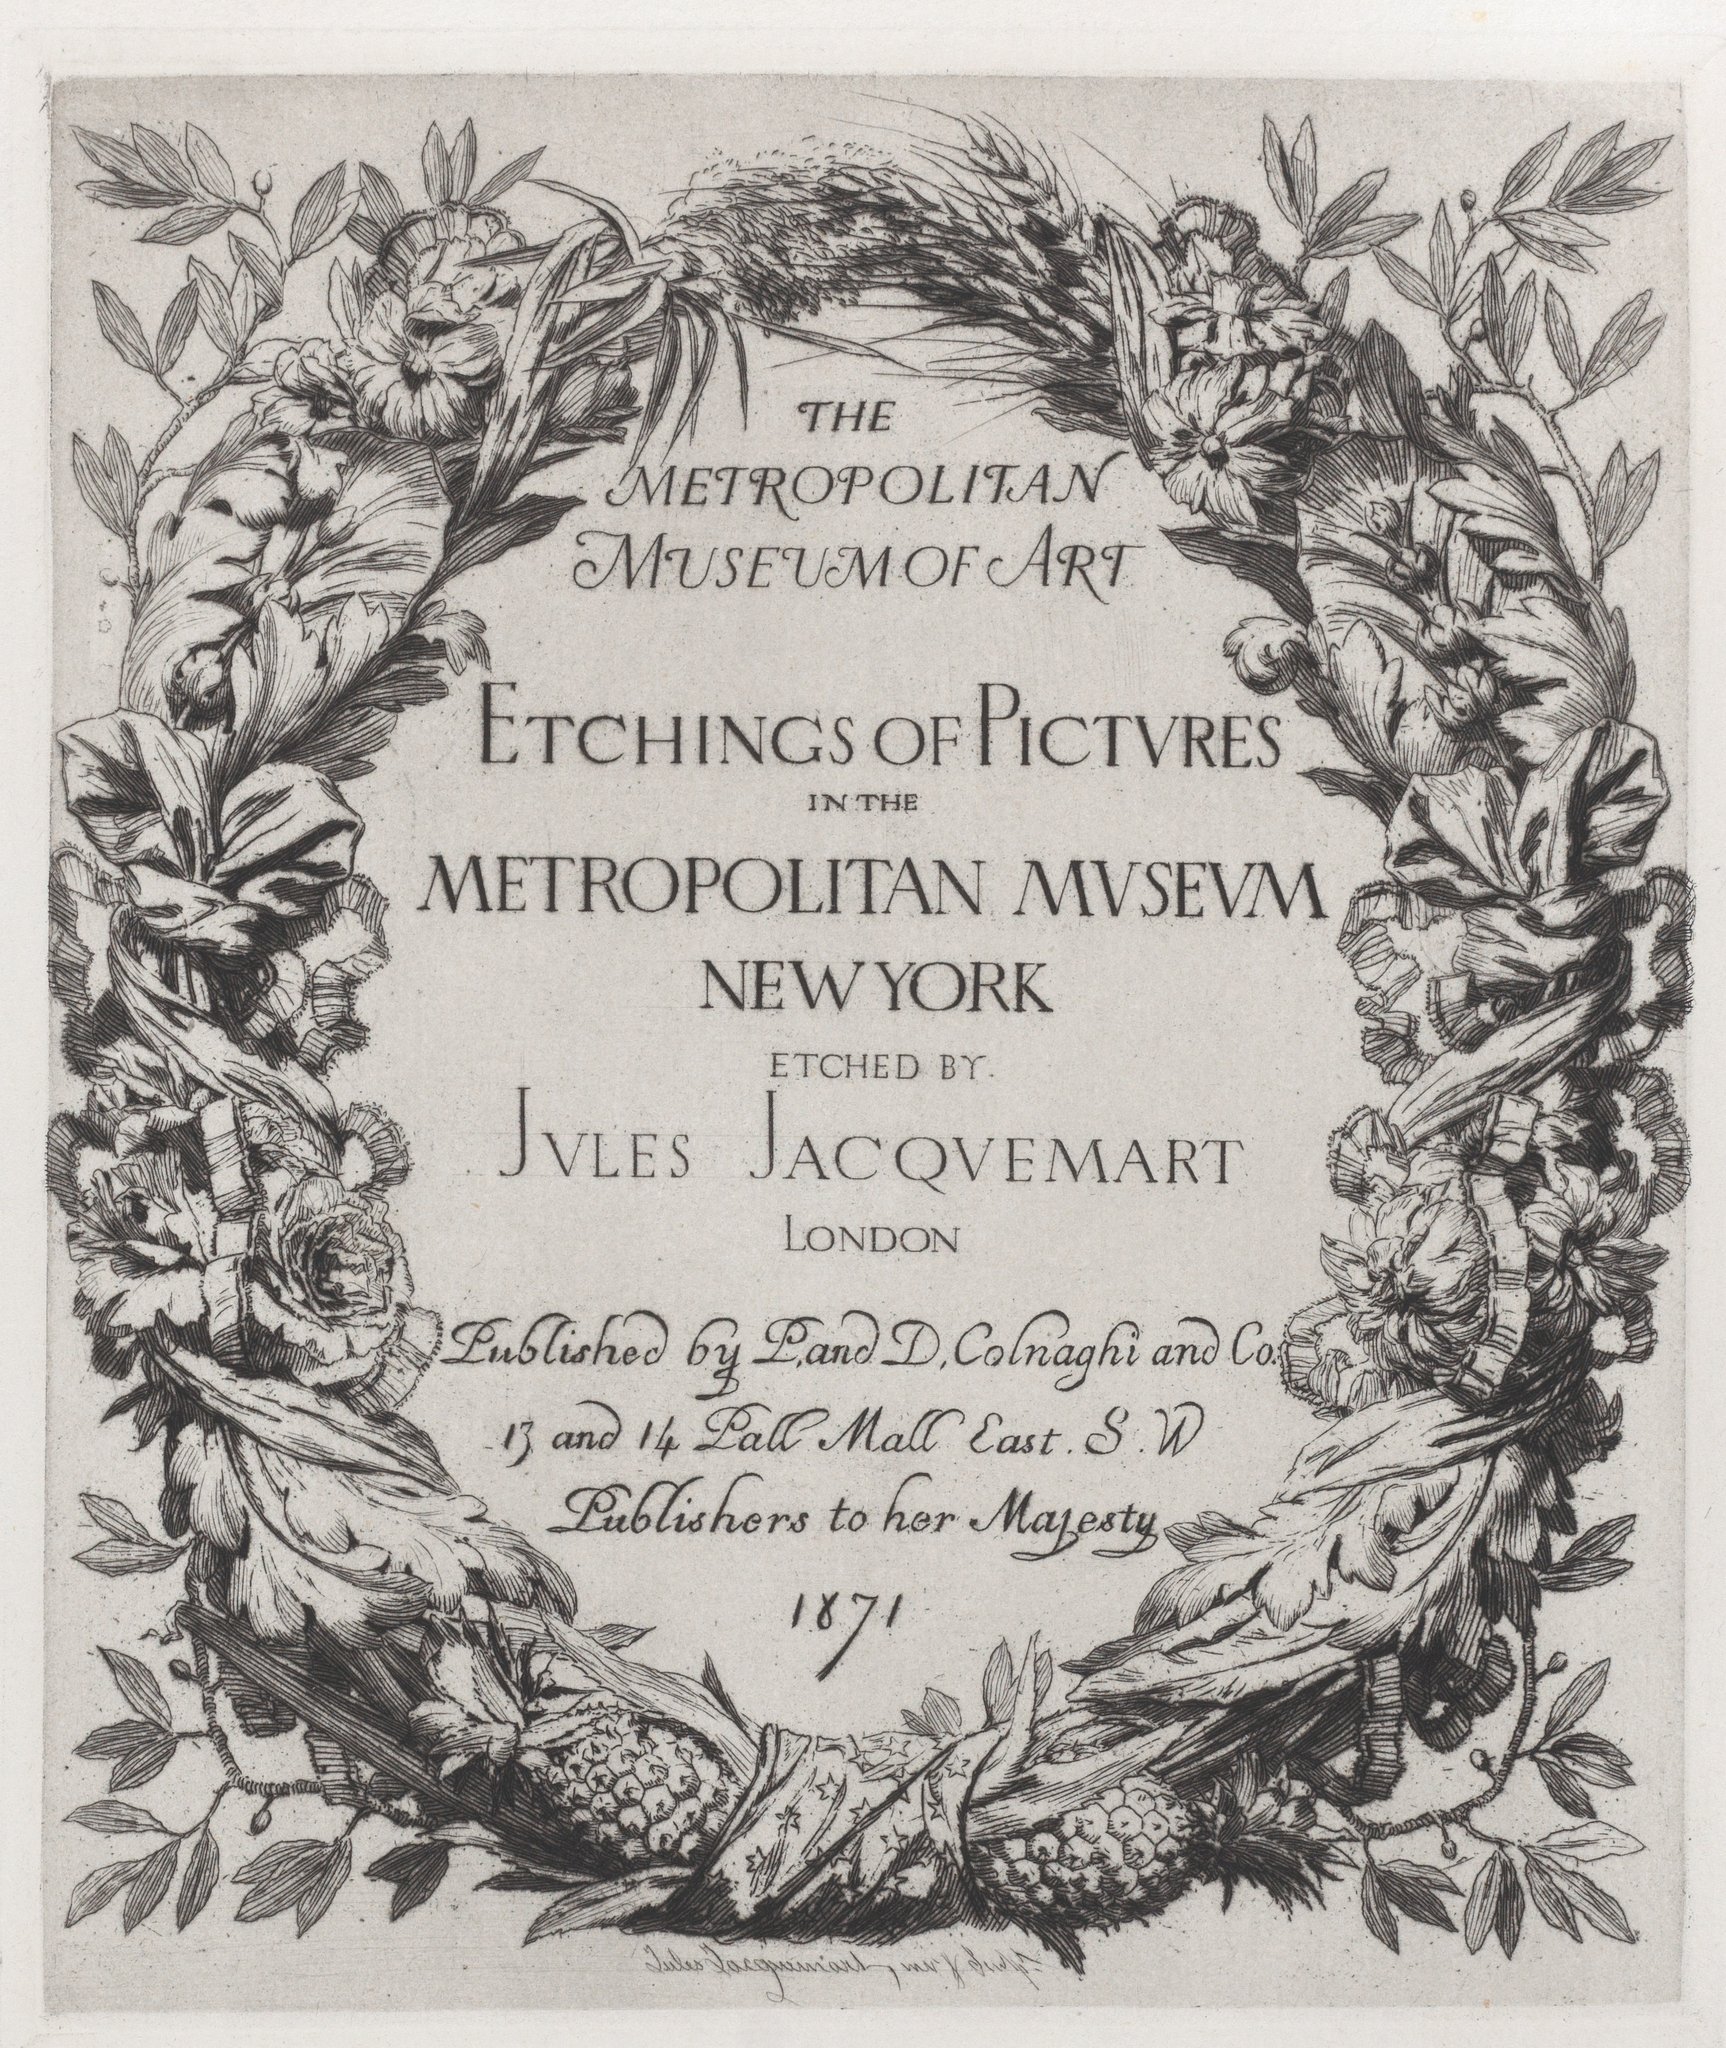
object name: print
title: Title page from "Etchings of Pictures in the Metropolitan Museum New York"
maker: jules-ferdinand jacquemart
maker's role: artist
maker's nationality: french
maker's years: 1837-1880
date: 1871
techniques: etching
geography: london